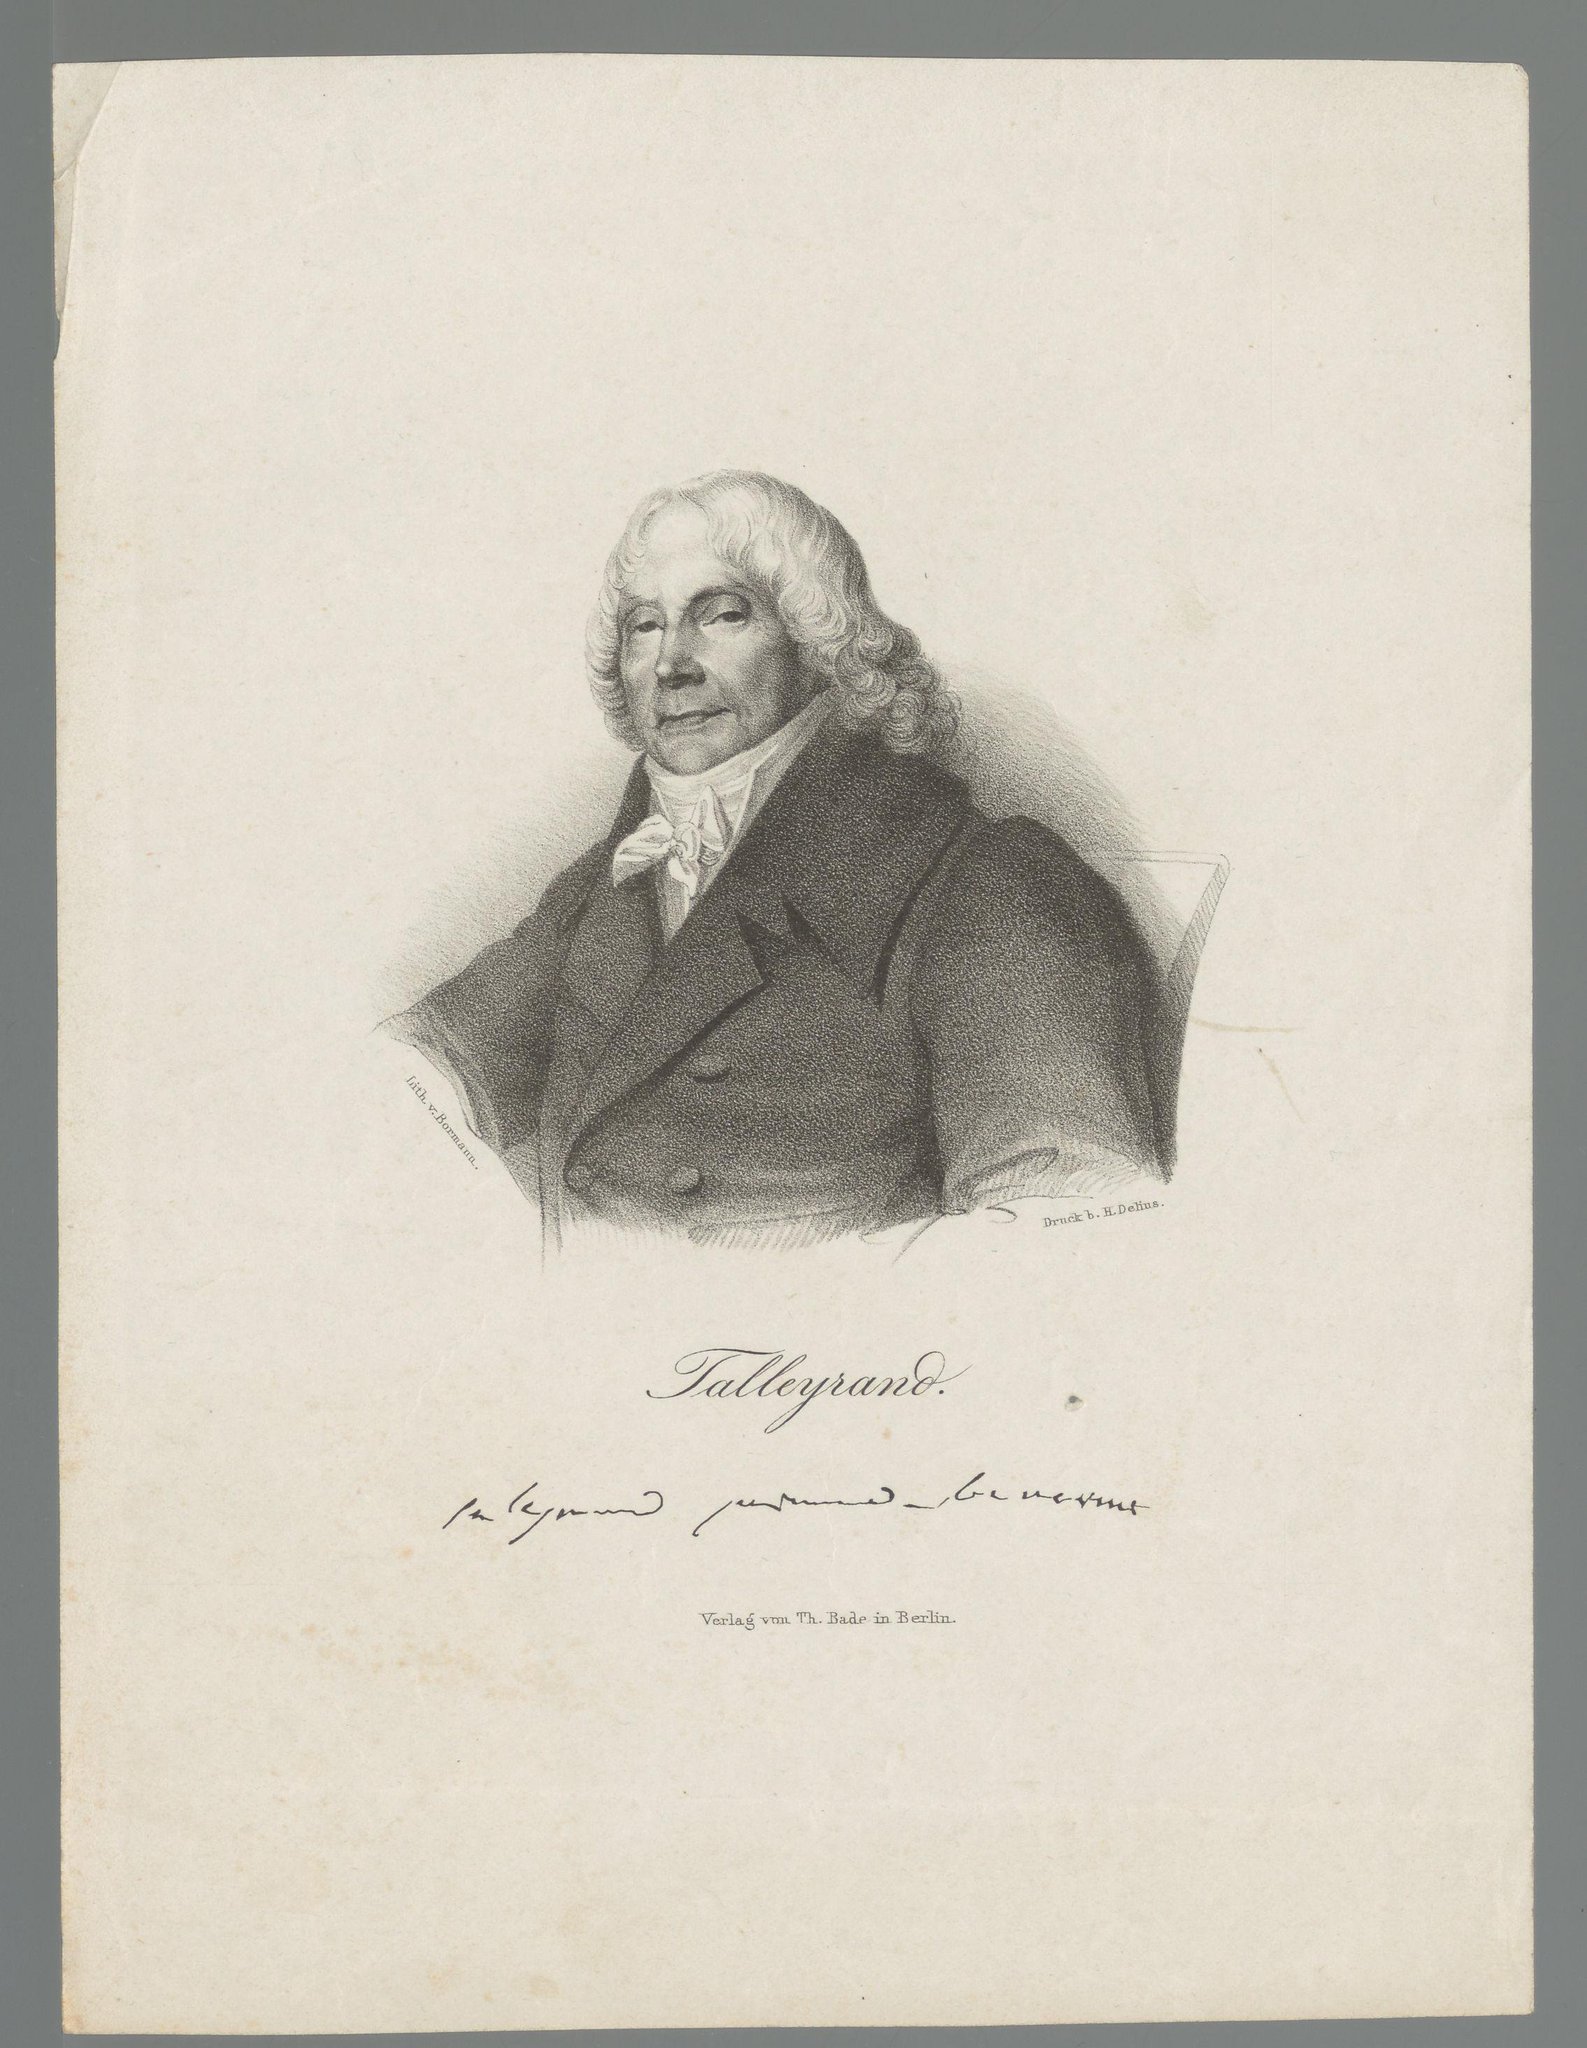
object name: print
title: Portret van Charles Maurice hertog van Talleyrand-Périgord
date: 1825-1850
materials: paper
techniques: lithograph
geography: berlin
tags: paris, politician, charles maurice hertog van talleyrand-périgord, adult man, historical persons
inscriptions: collector's mark: Lugt 2228